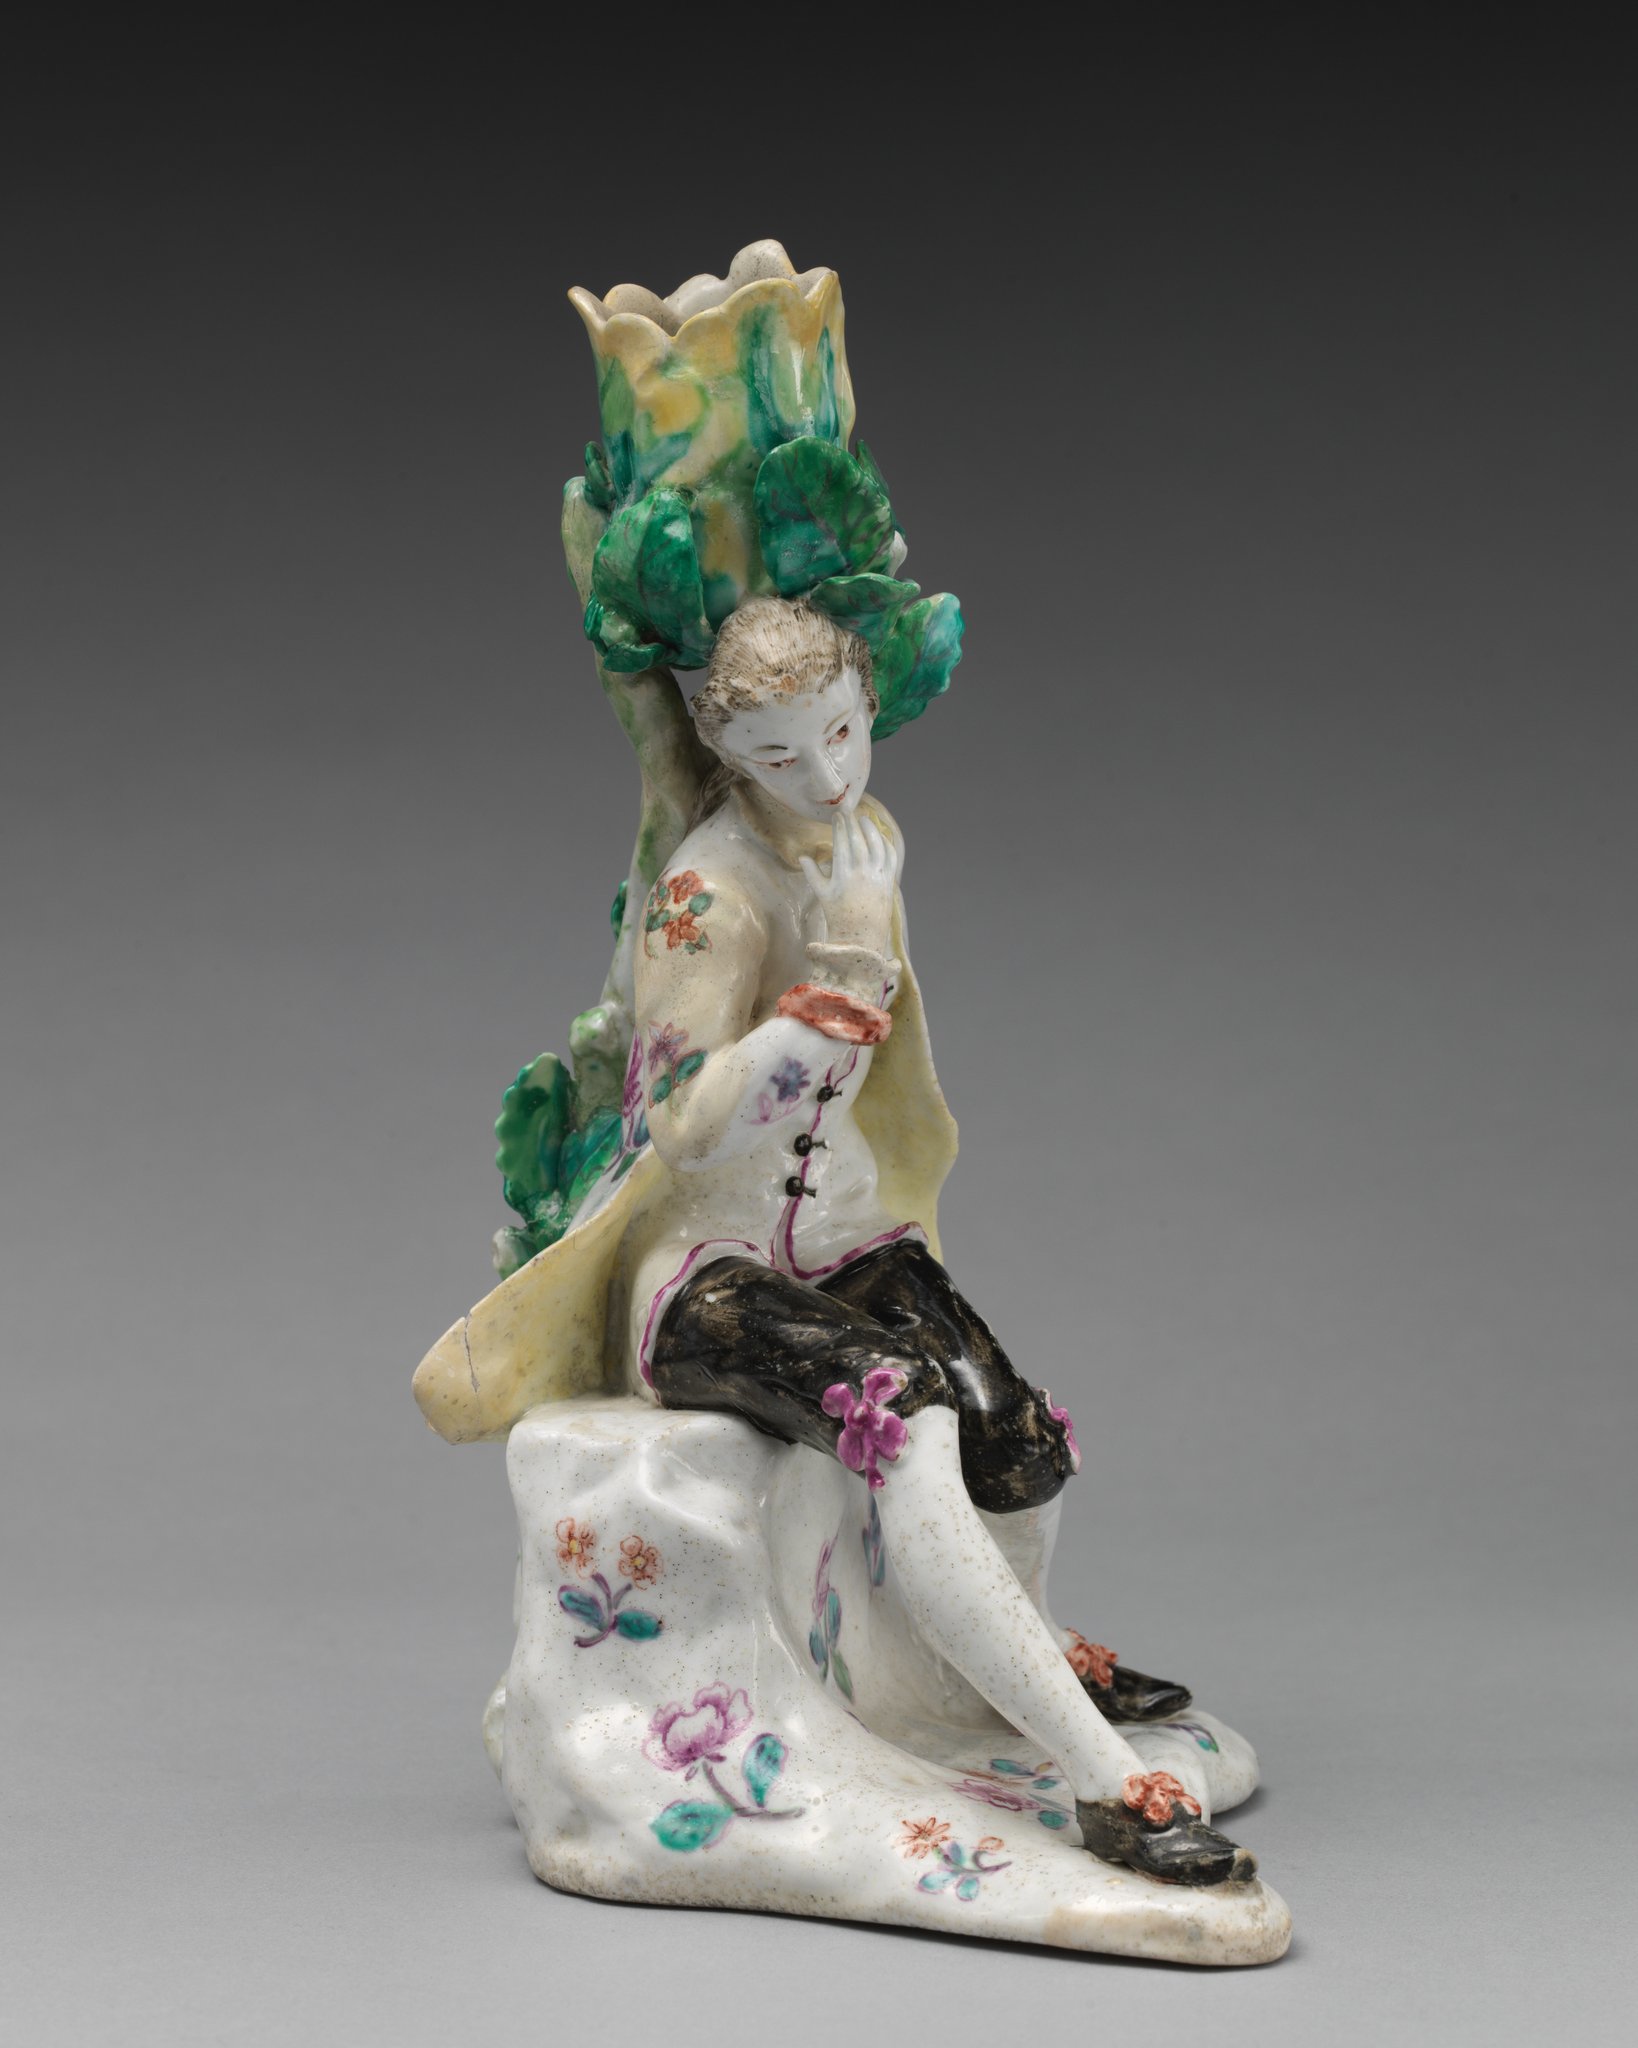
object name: candlestick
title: Candlestick in the form of a male dozing figure (one of a pair)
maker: saint james's factory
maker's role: maker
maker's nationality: british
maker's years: 1749-1759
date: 1750-1759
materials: soft paste porcelain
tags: women